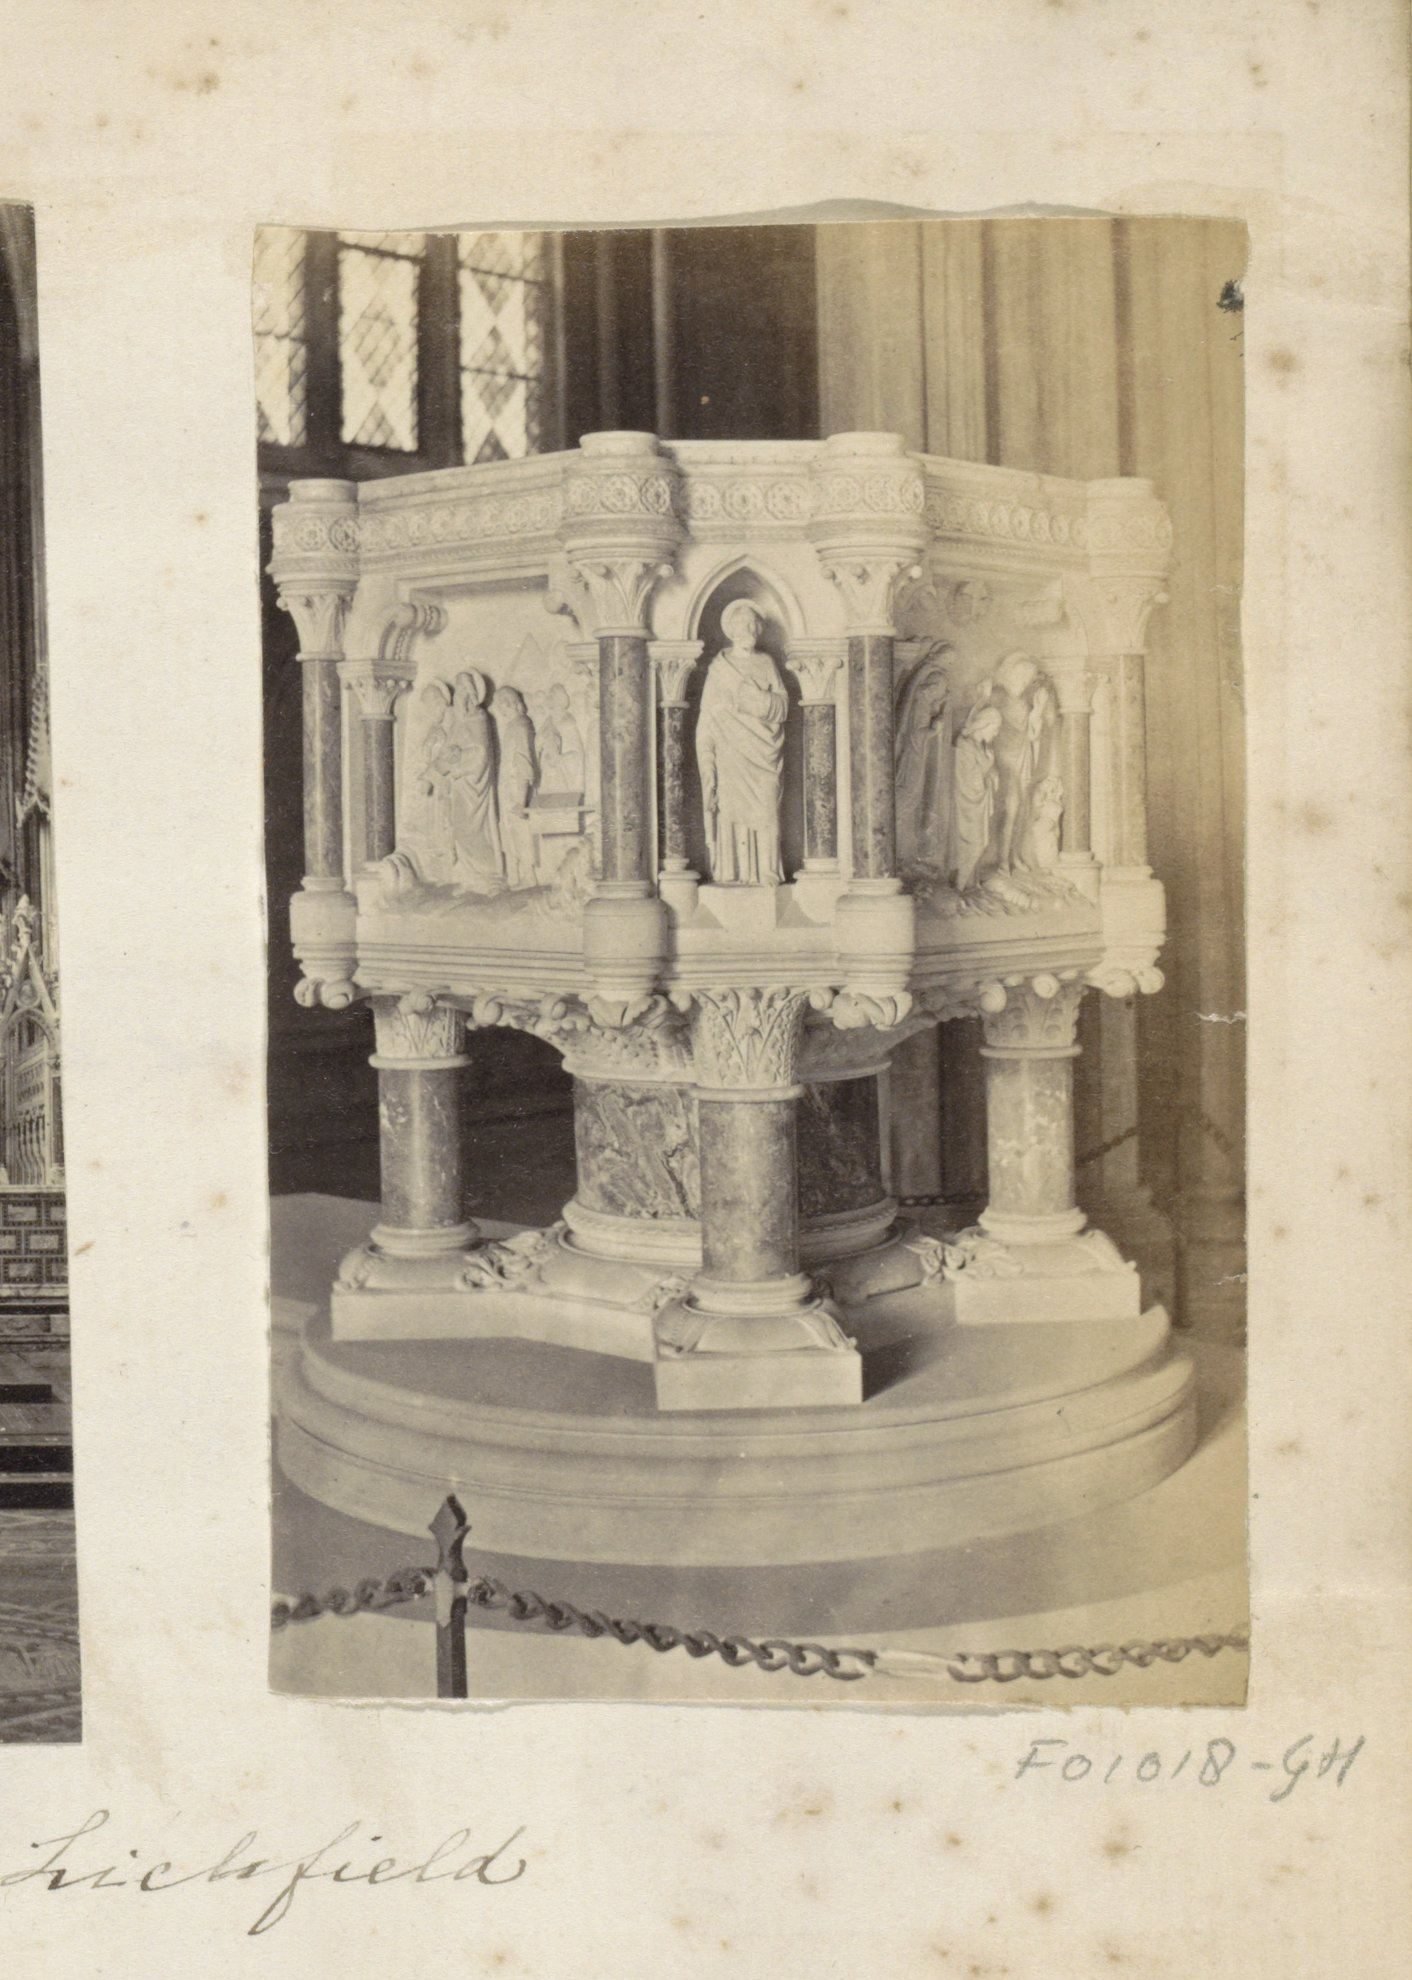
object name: photograph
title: Lichfield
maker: Anonymous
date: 1860-1870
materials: paper, photographic support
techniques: albumen print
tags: piece of sculpture, reproduction of a piece of sculpture (+ sculpture), baptismal font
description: Onderdeel van Engels familiealbum met foto's van personen, reizen, cricket en kunstwerken.